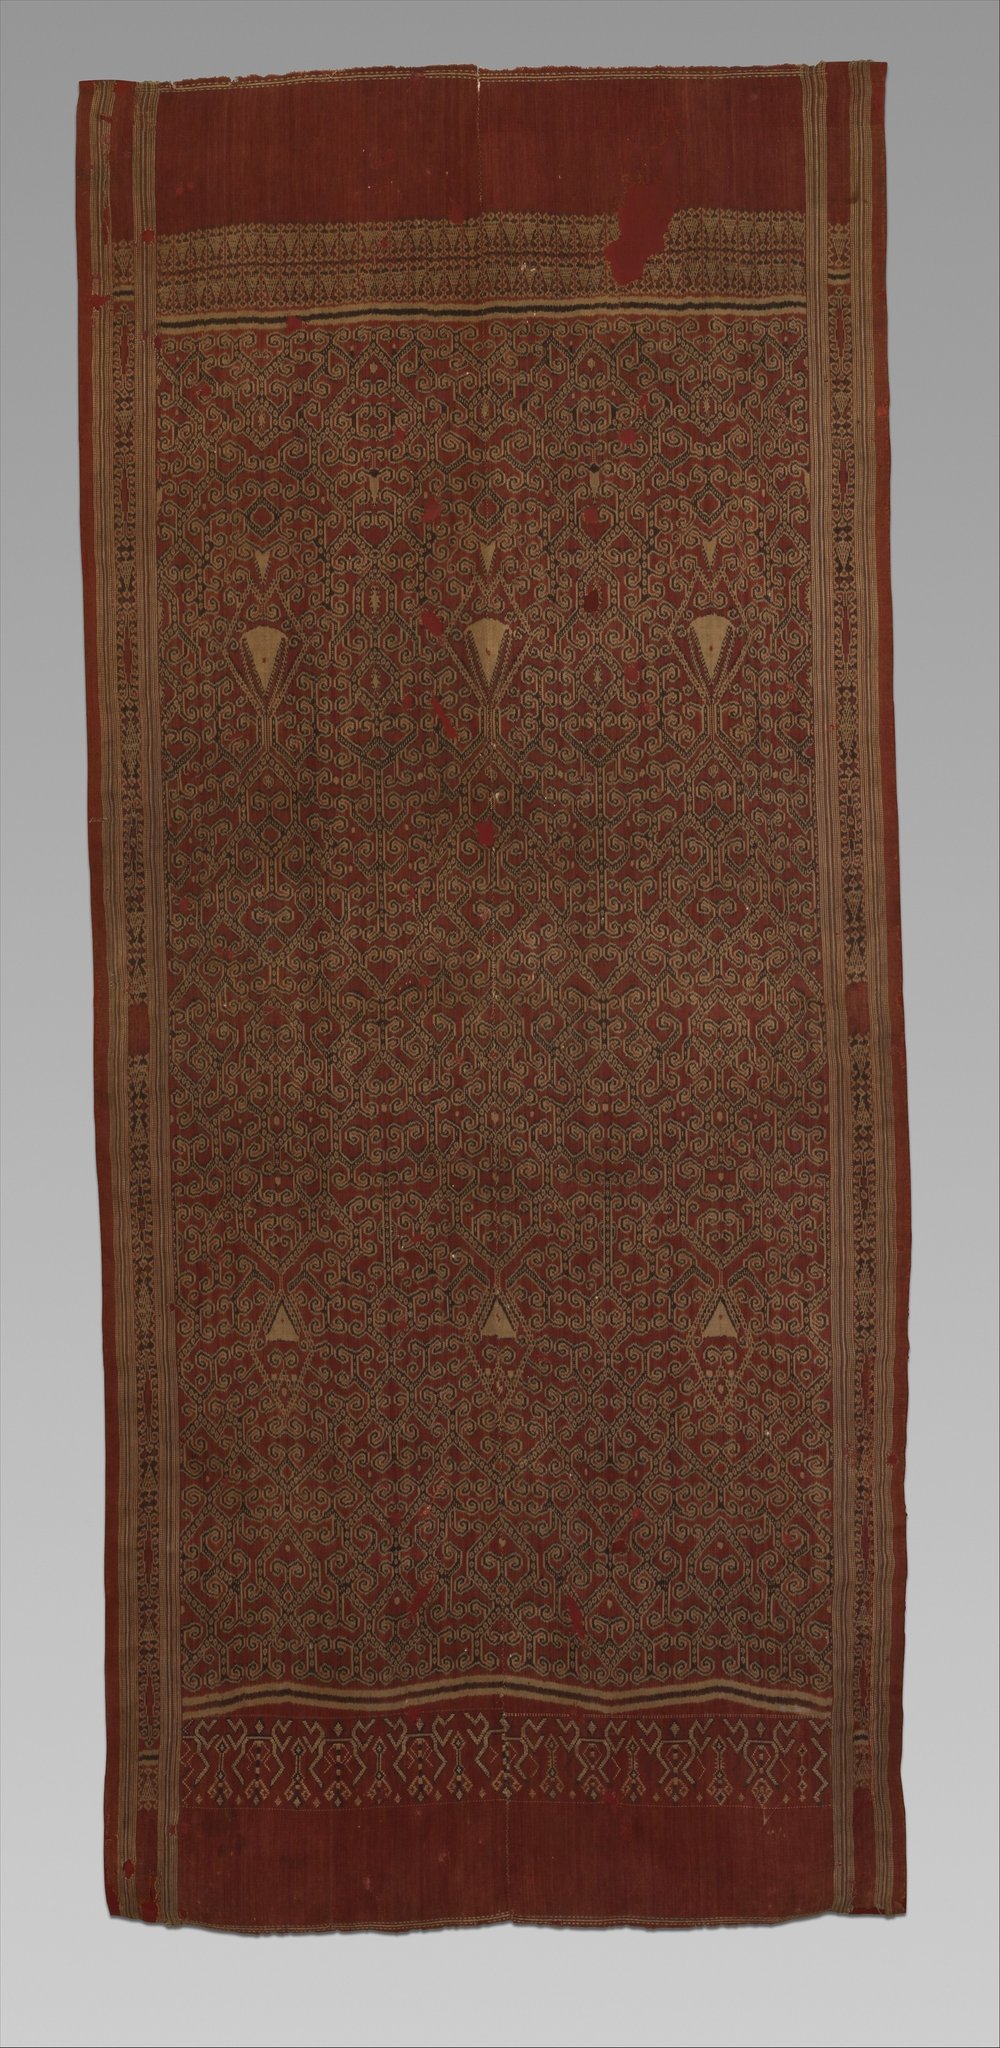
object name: textile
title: Ceremonial Textile (Pua Kumbu)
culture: iban people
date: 1701-1800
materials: cotton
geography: malaysia